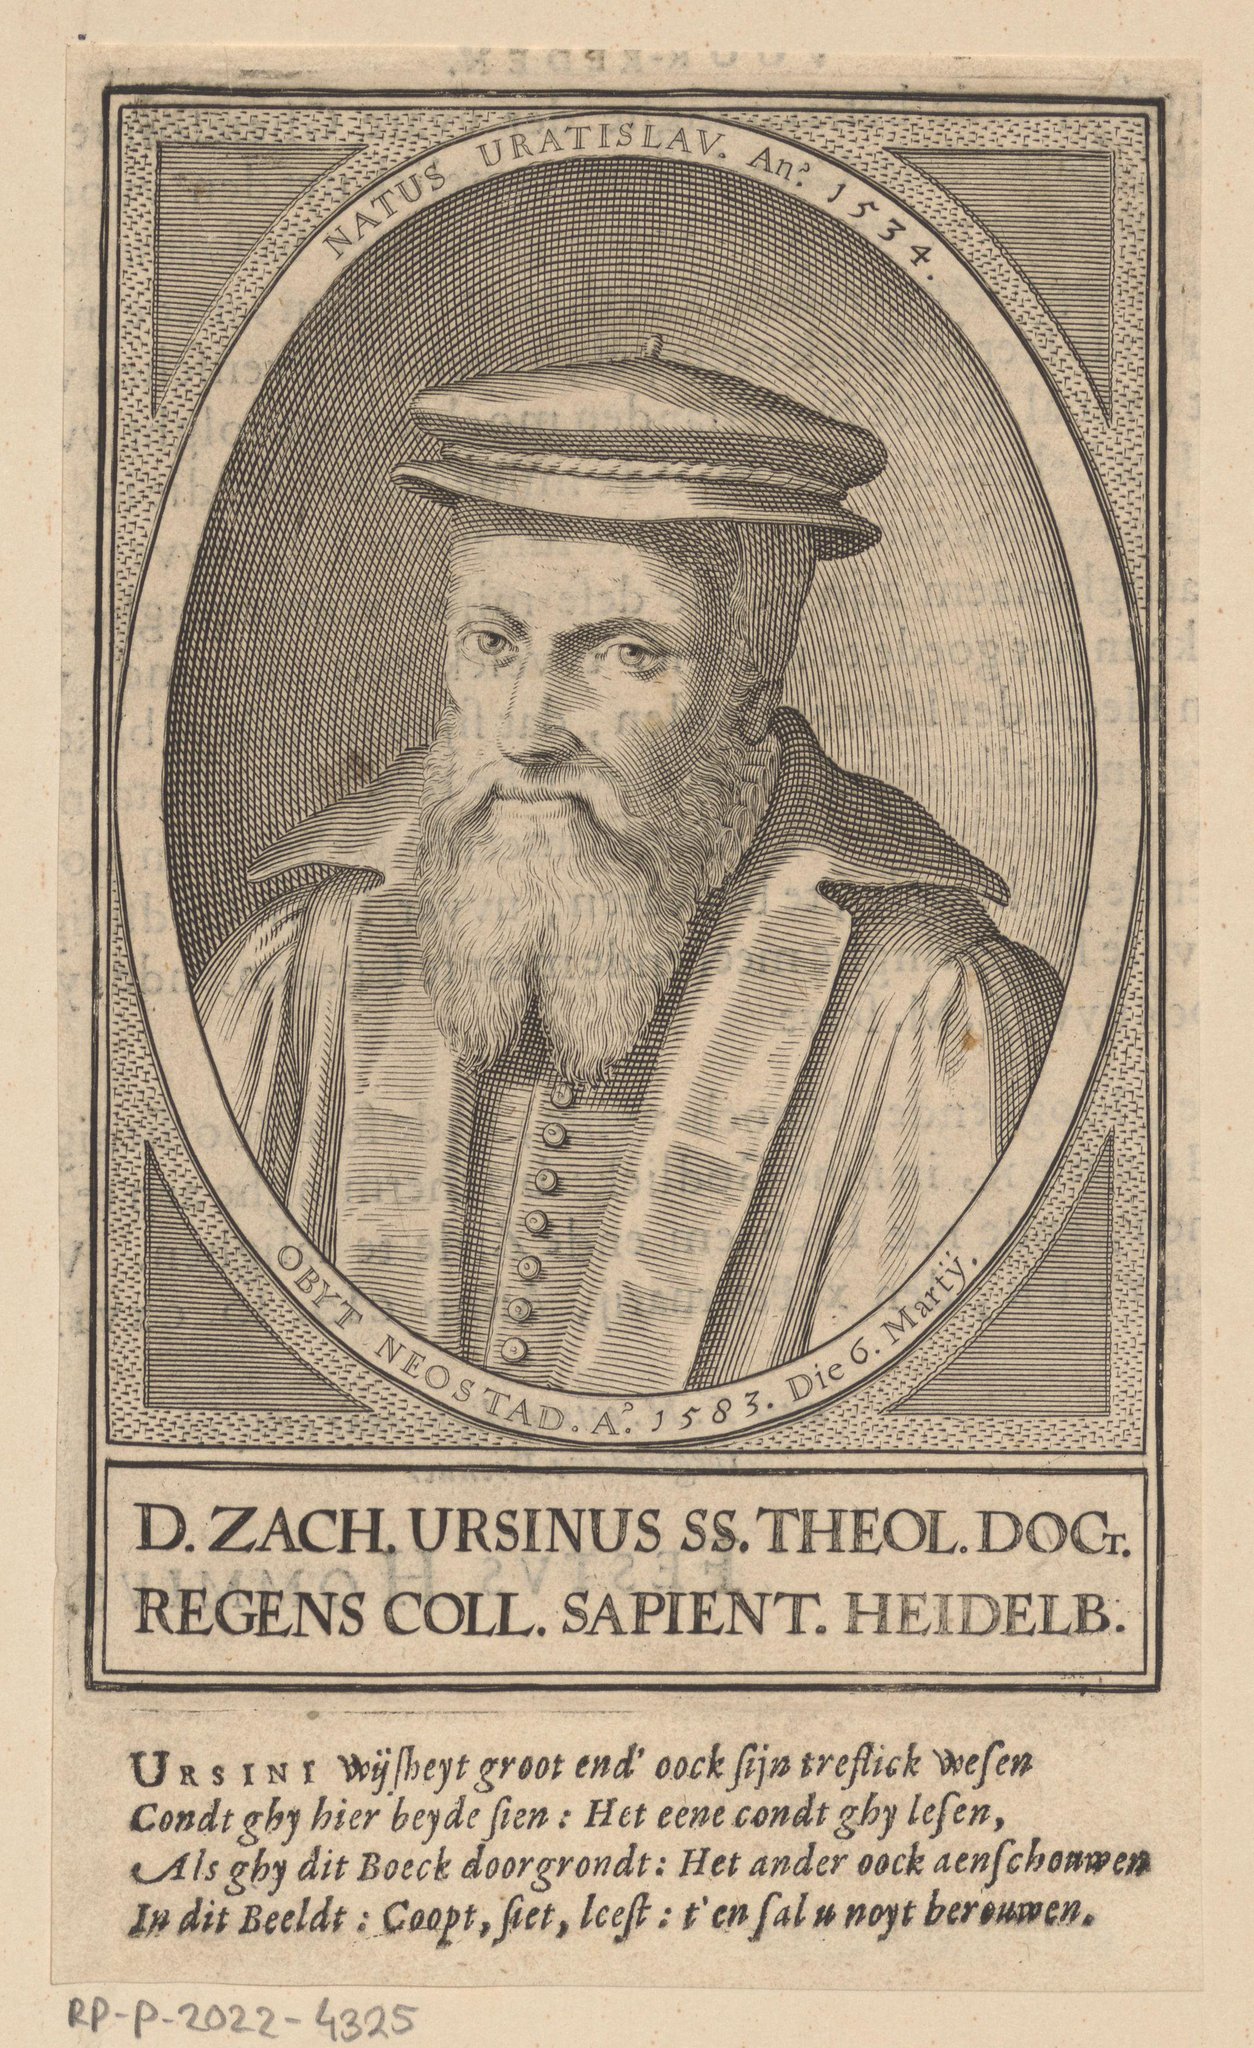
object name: book illustration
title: Portret van Zacharias Ursinus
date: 1617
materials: paper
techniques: engraving, letterpress printing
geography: leiden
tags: theologian, historical persons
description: Prent uit: Ursinus, Zacharius, Festus Hommius. Het schat-boeck der verclaringhen over de Catechismus der christelicke religie (...). Leiden: Andries Clouck, 1617.